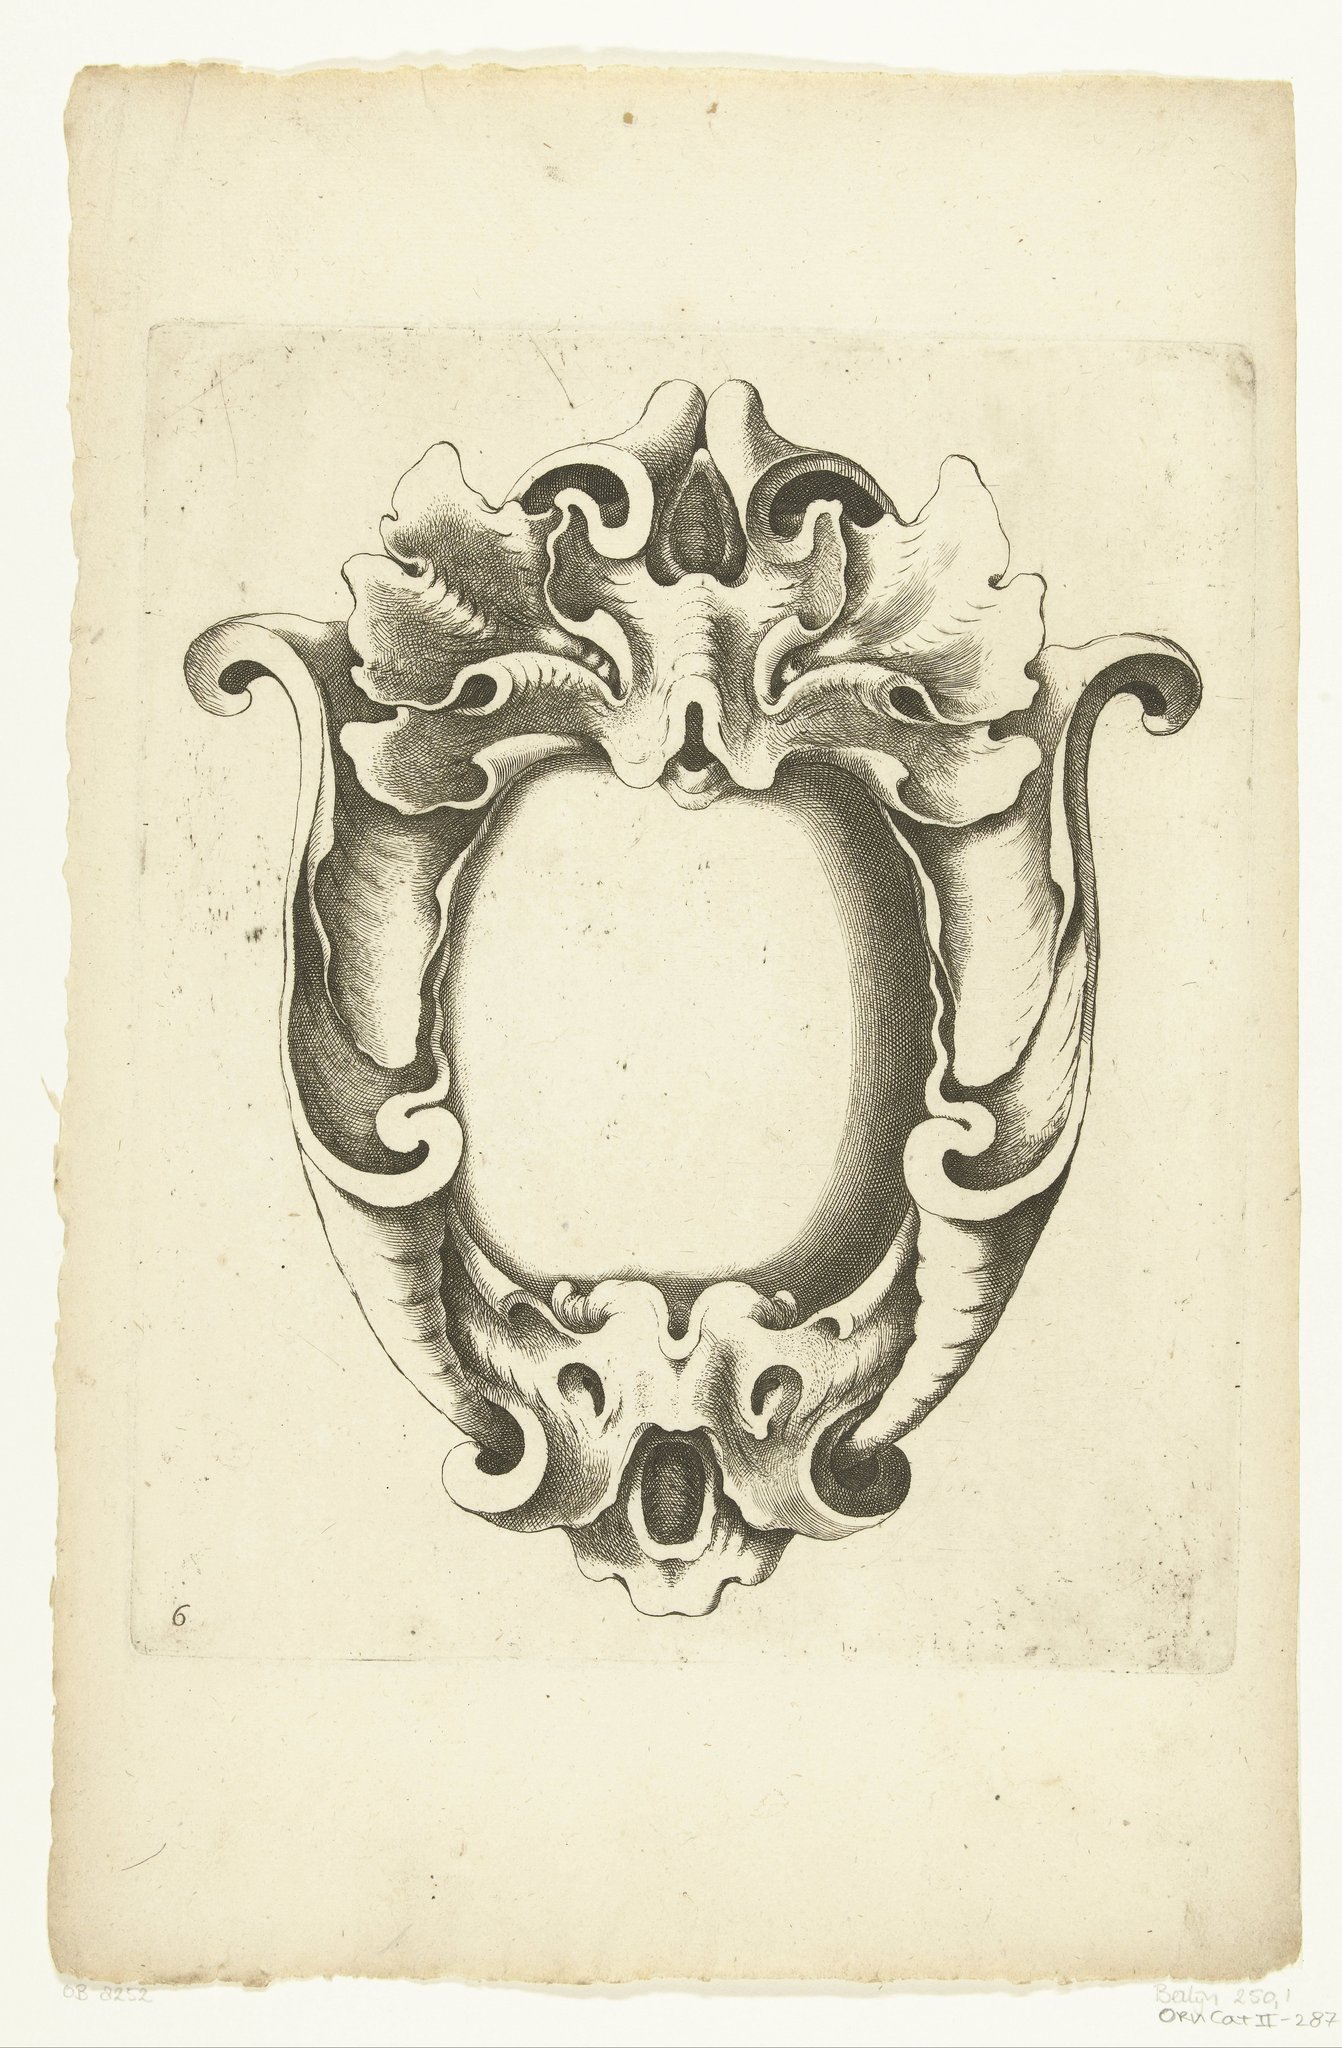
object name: ornament print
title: Cartouche met twee maskers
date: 1654-1678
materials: paper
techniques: etching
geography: amsterdam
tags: ornament ~ cartouche, mask, mascaron ~ ornament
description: Bovenaan een masker met uitwaaierende vormen, onderaan een tweede masker.